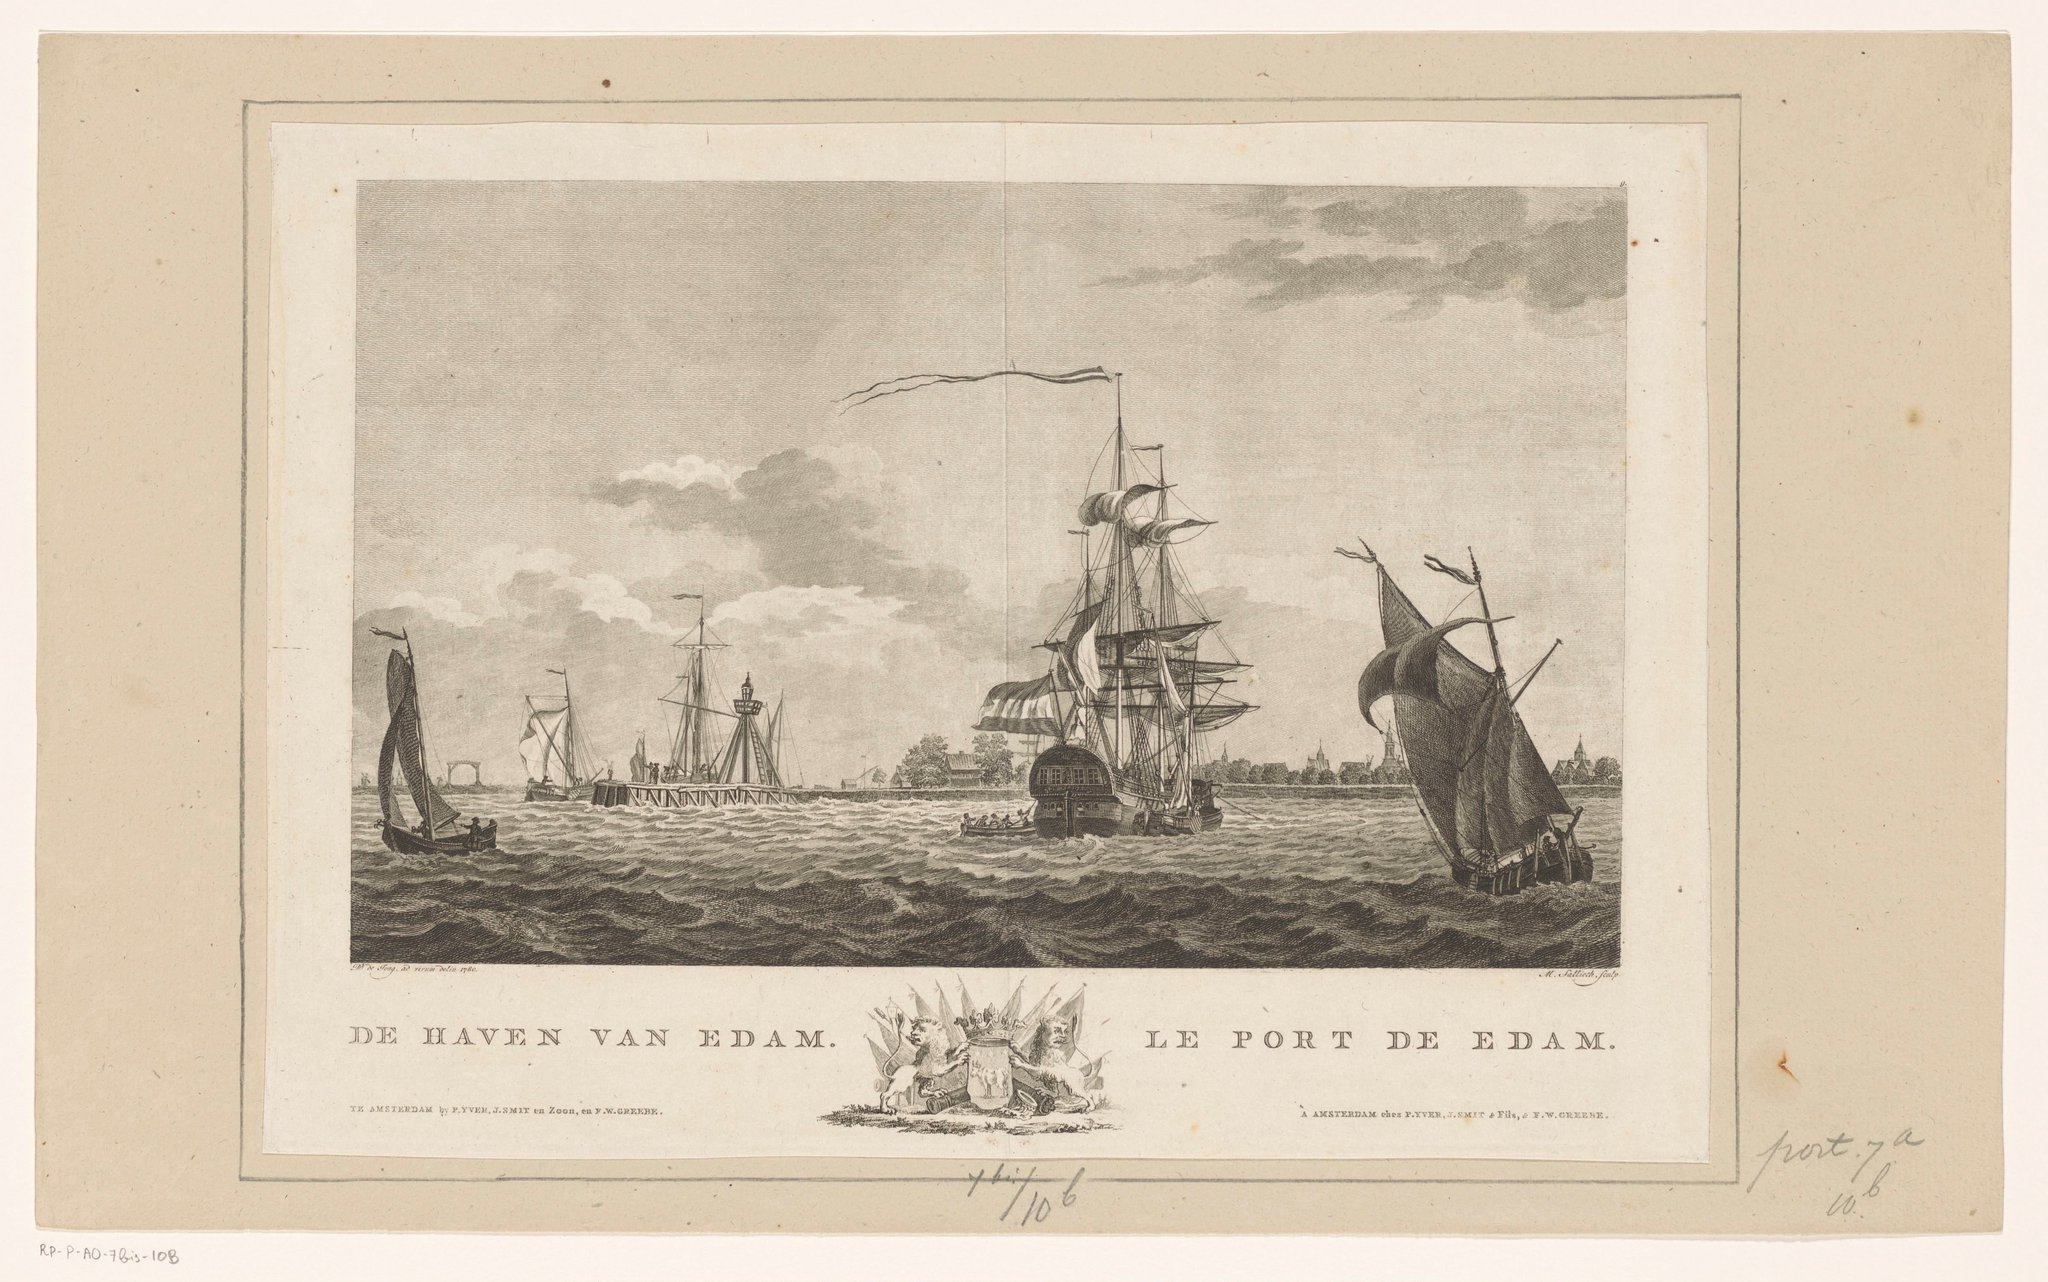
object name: print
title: De haven van Edam / Le port de Edam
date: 1780-1787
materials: paper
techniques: etching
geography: amsterdam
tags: harbour, coat of arms (as symbol of the state, etc.) (+ city; municipal), sailing-ship, sailing-boat, zuiderzee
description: Latere staat ook gebruikt in: Aa, Cornelis van der. Atlas van de zeehavens der Bataafsche Republiek. Met derzelver beschrijvingen in XXXI kunstplaaten / Atlas van de zeehavens der Bataafsche Republiek, die van Batavia en Onrust. Mitsgaders de afbeeldingen van de haringvisscherij en de walvischvangst (…). Amsterdam: Evert Maaskamp, 1805.